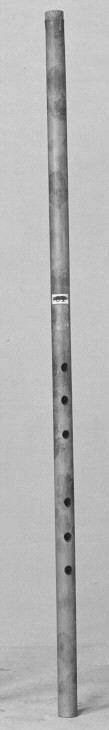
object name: souling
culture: bornean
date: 1867-1900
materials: bamboo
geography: borneo